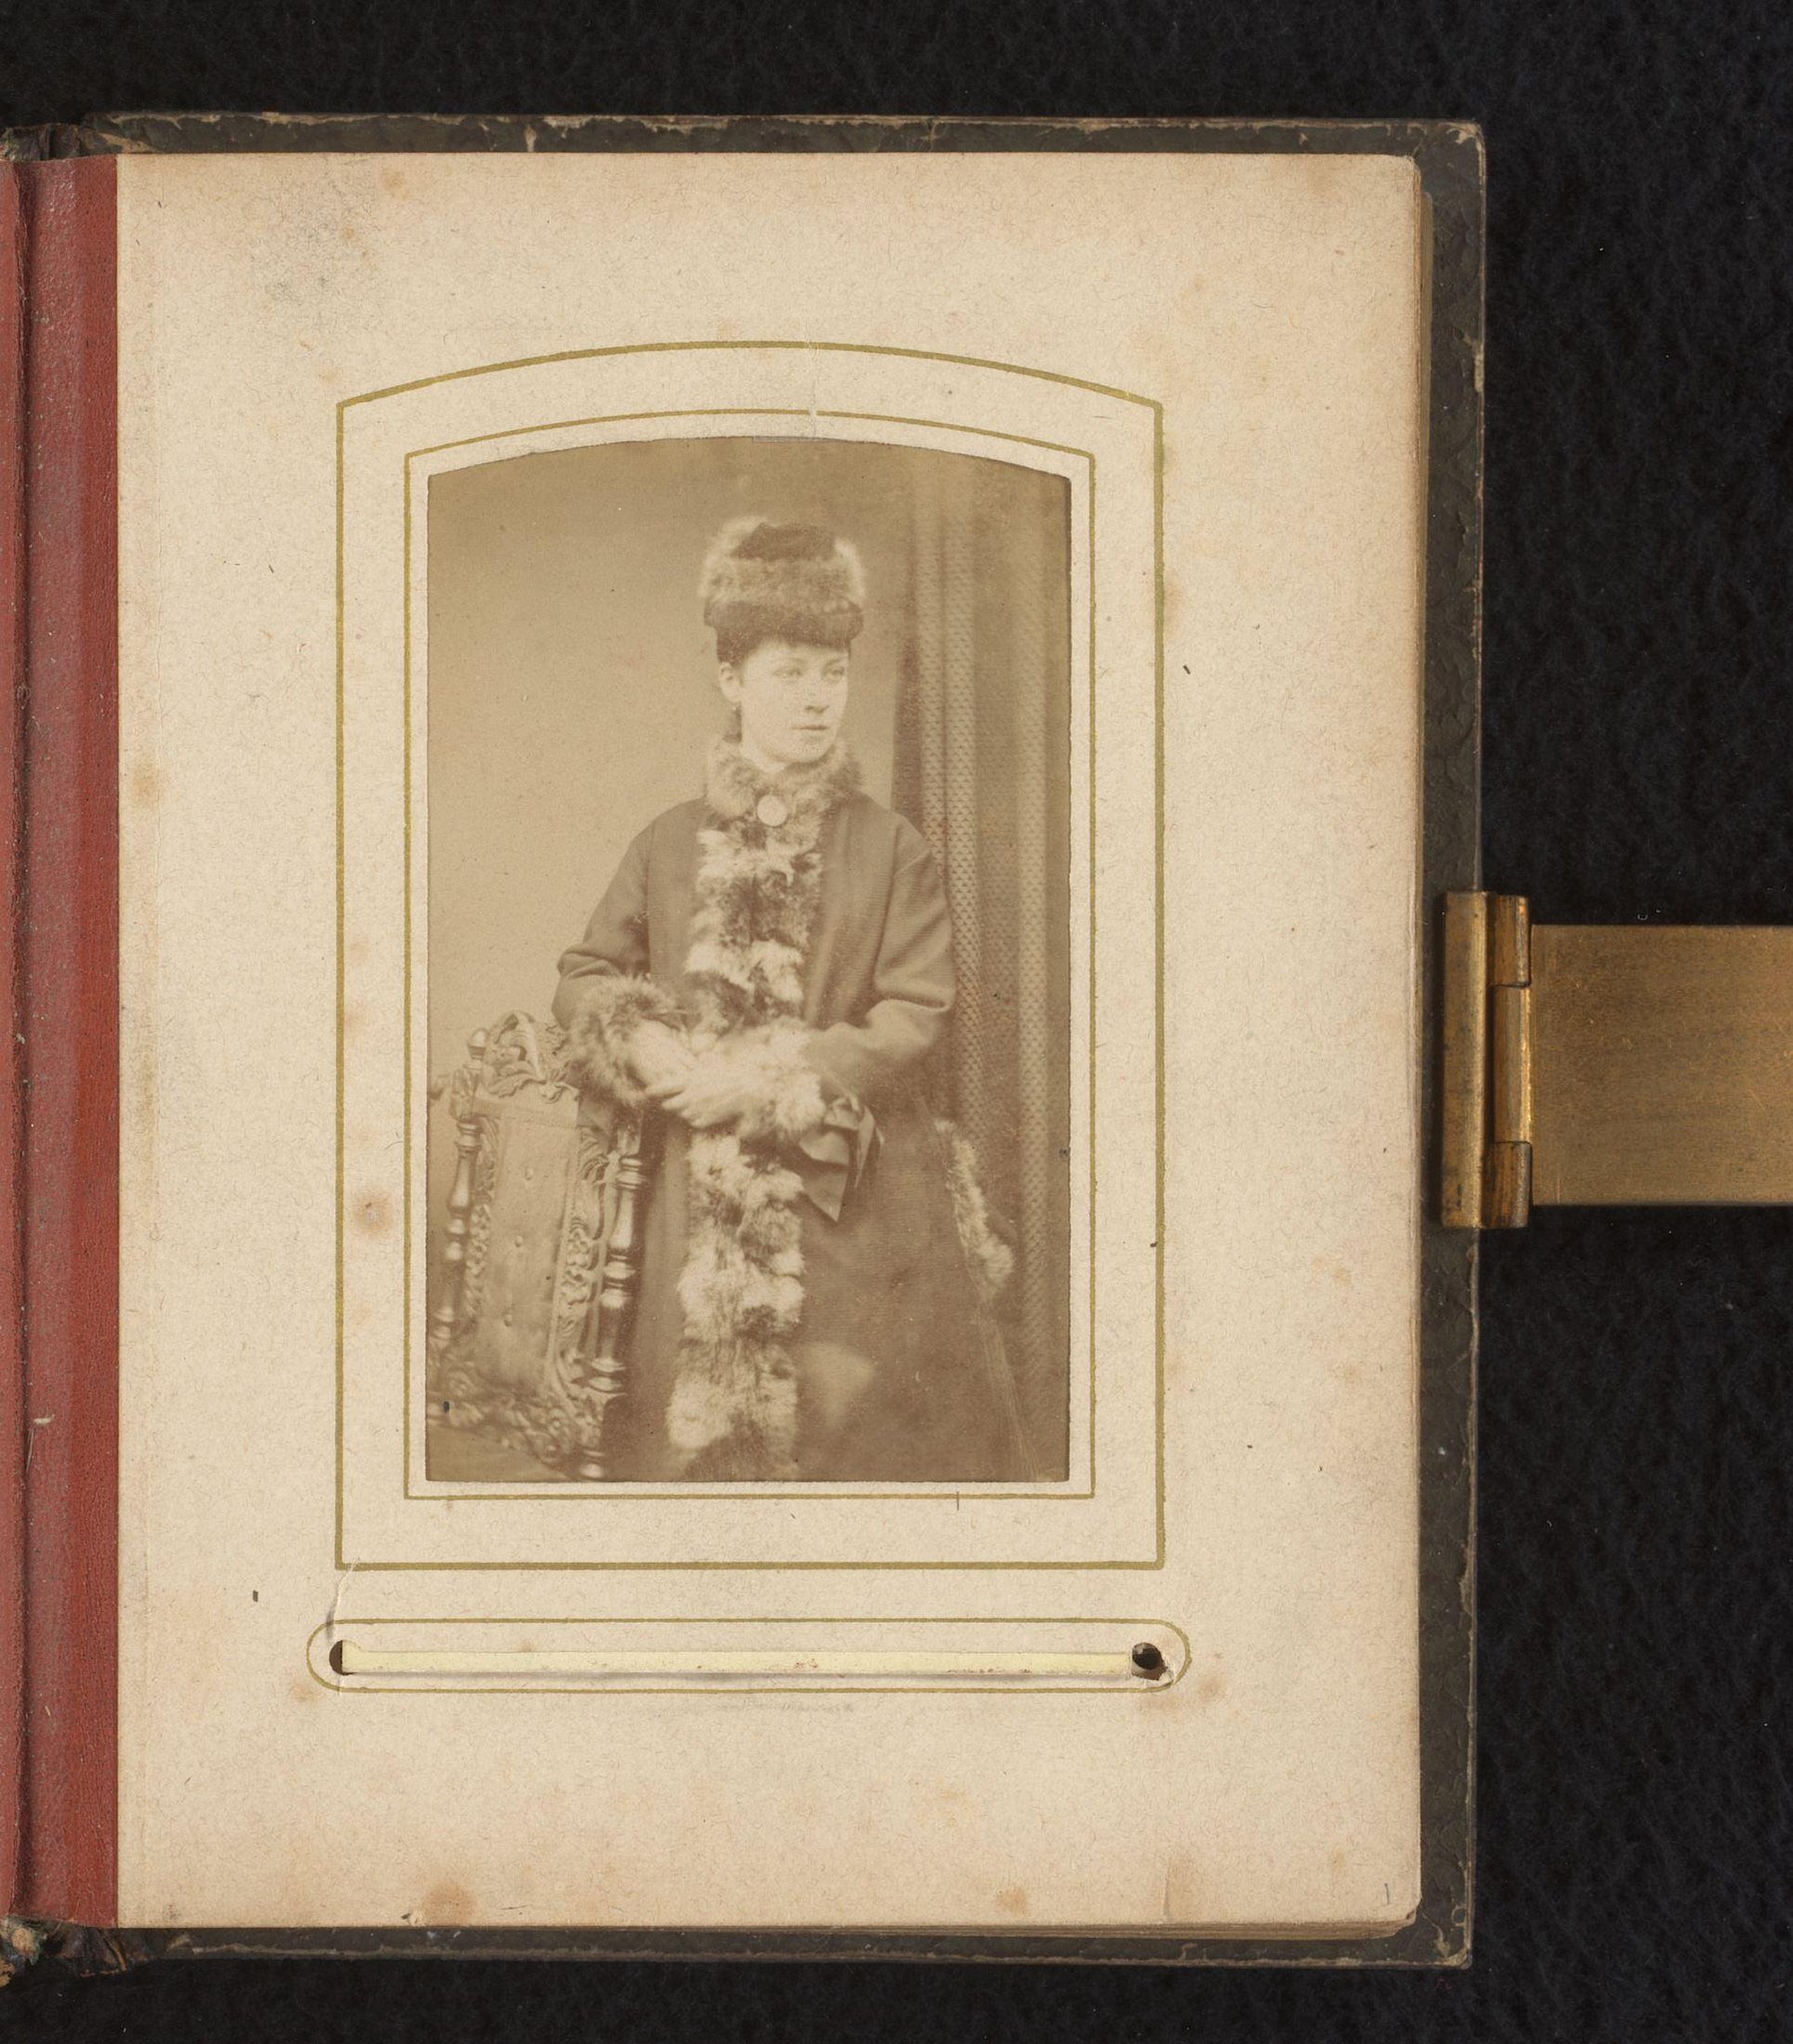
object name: photograph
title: Portret van een vrouw in mantel met bont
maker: william daniel darnell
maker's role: fotograaf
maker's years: 1833-1911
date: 1860-1900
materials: cardboard, photographic support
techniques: albumen print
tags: adult woman, head-gear, historical persons, coat, cape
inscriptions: inscription: ‘37, Chandos Street/ Charing Cross’, inscription: ‘Artist and Photographer/ W. Darnel/ Copies may be had at any time’